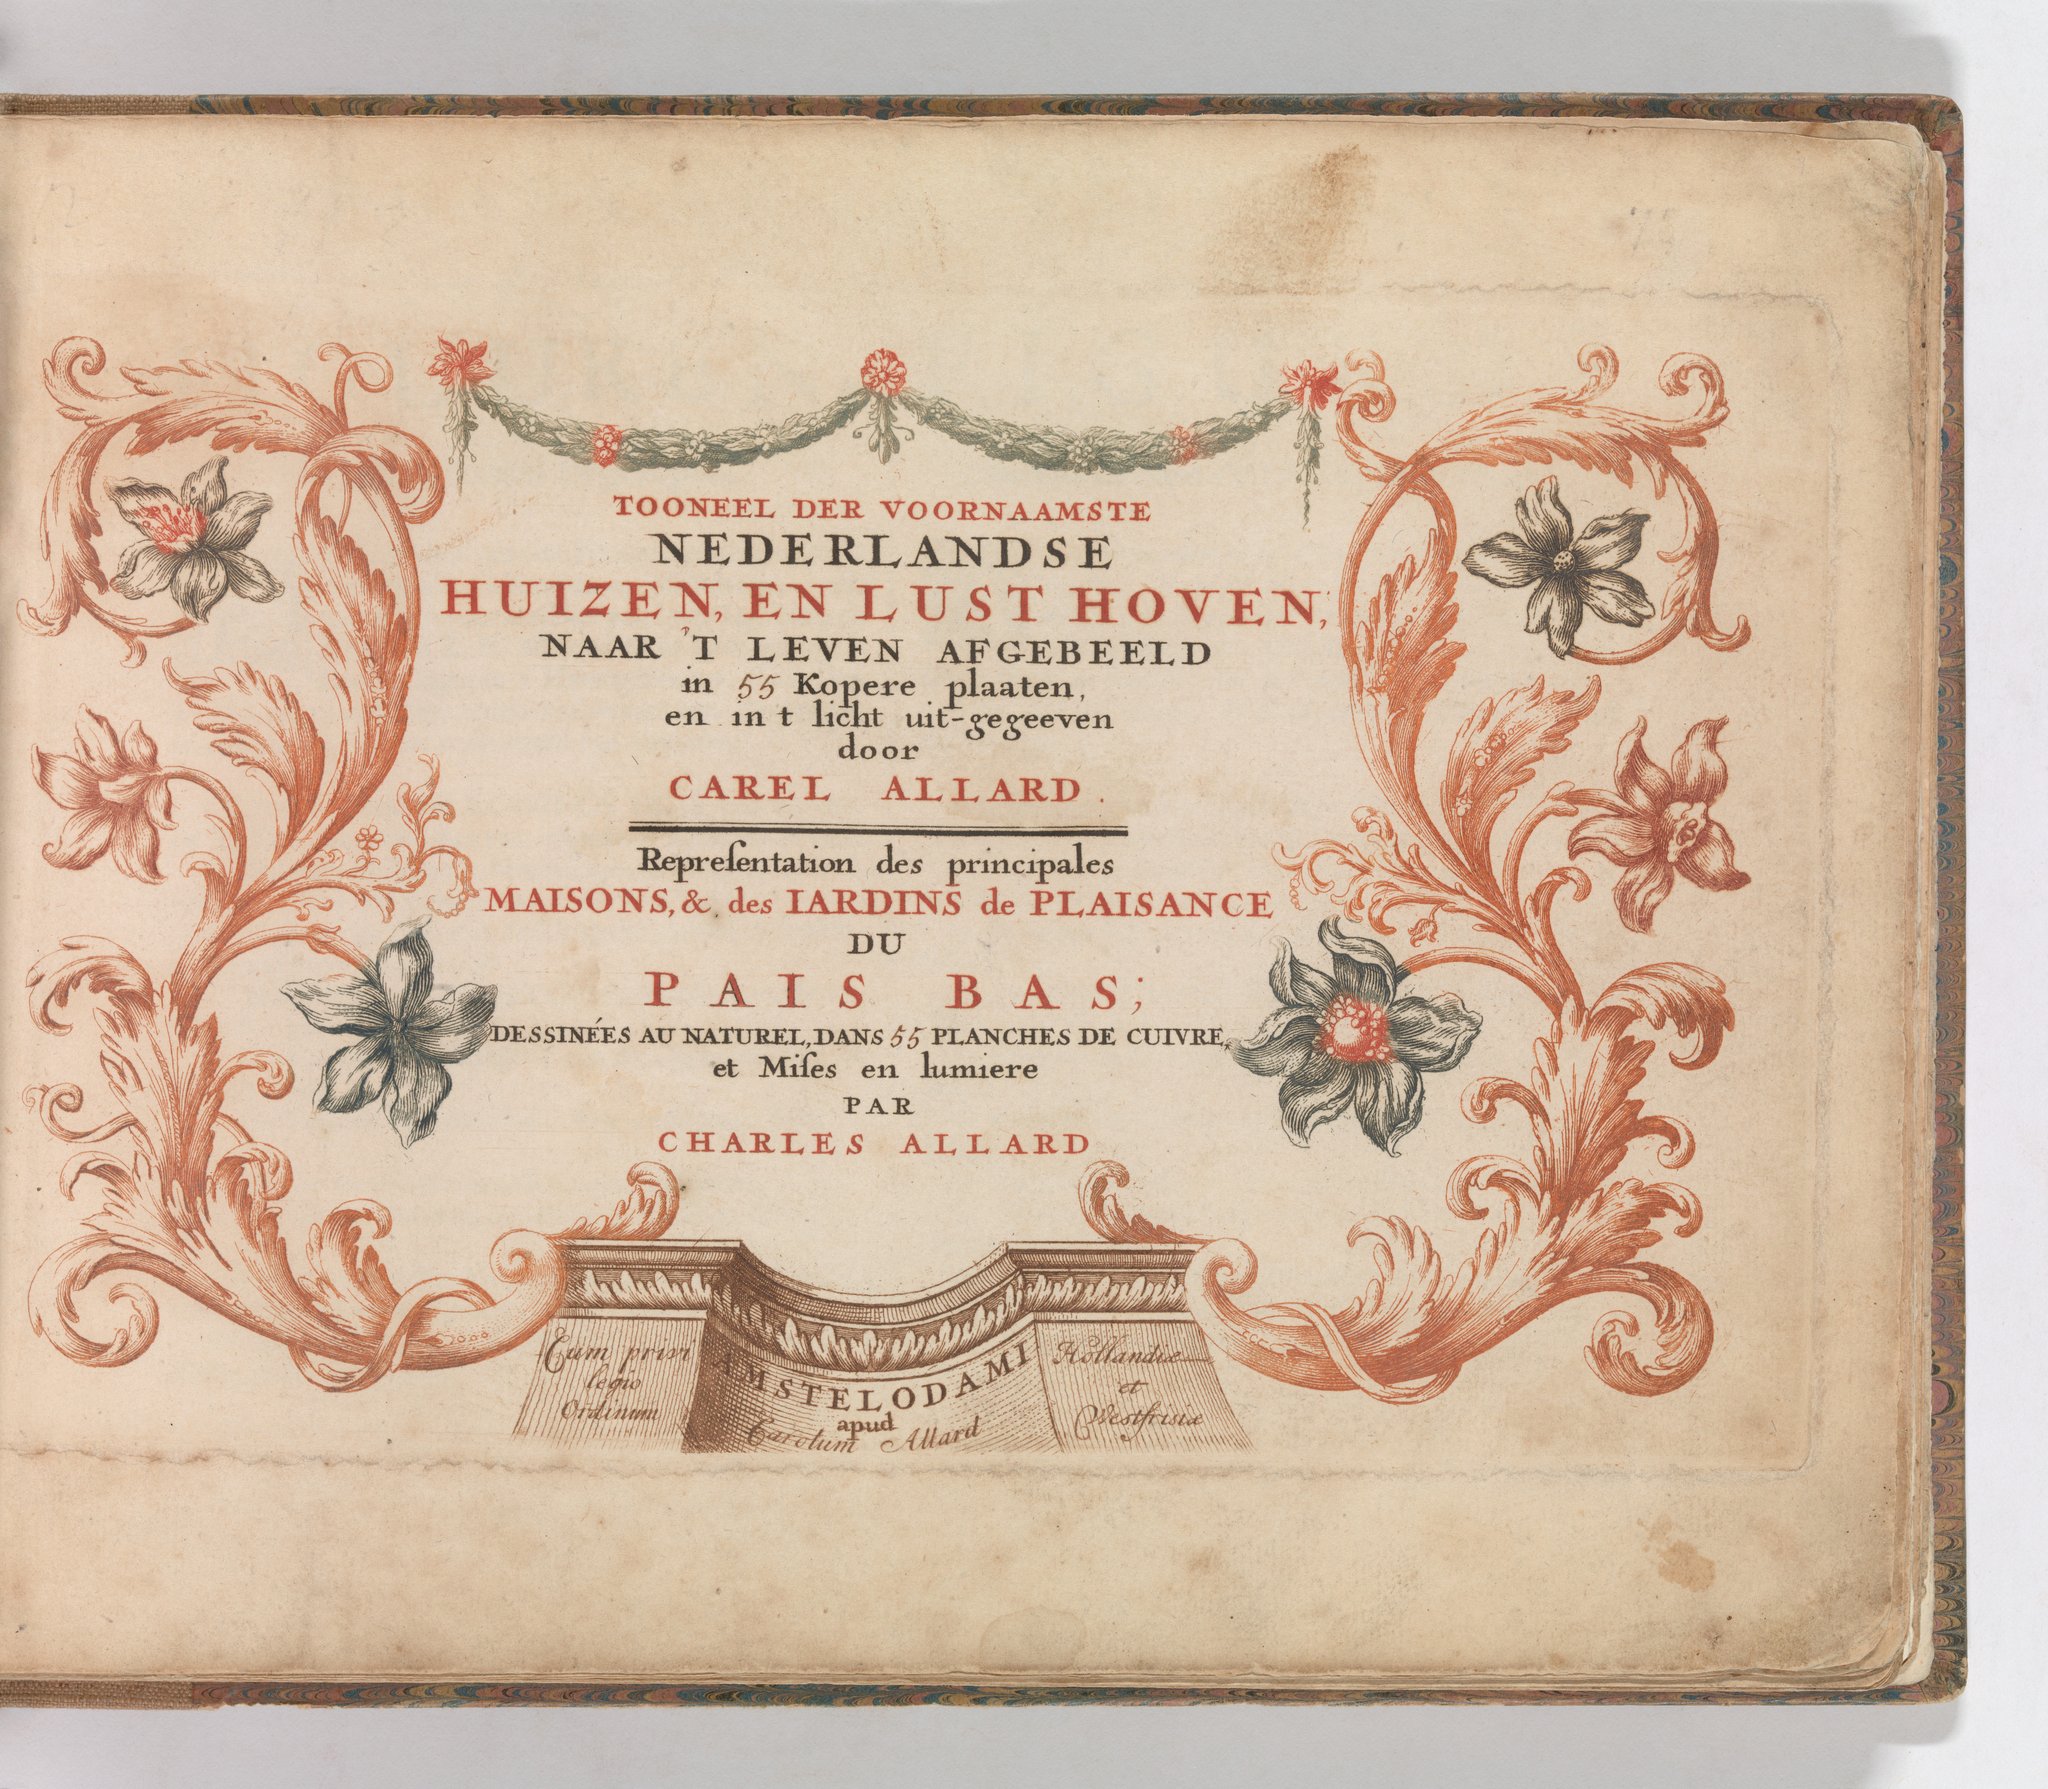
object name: book print ornament architecture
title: Title Page to 'Tooneel Der Voornaamste Nederlands Huizen, En Lust Hoven, Naar T Leven Afgebeeld'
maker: carel allard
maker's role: publisher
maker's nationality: dutch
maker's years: 1648-1709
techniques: engraving, lithography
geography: amsterdam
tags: flowers